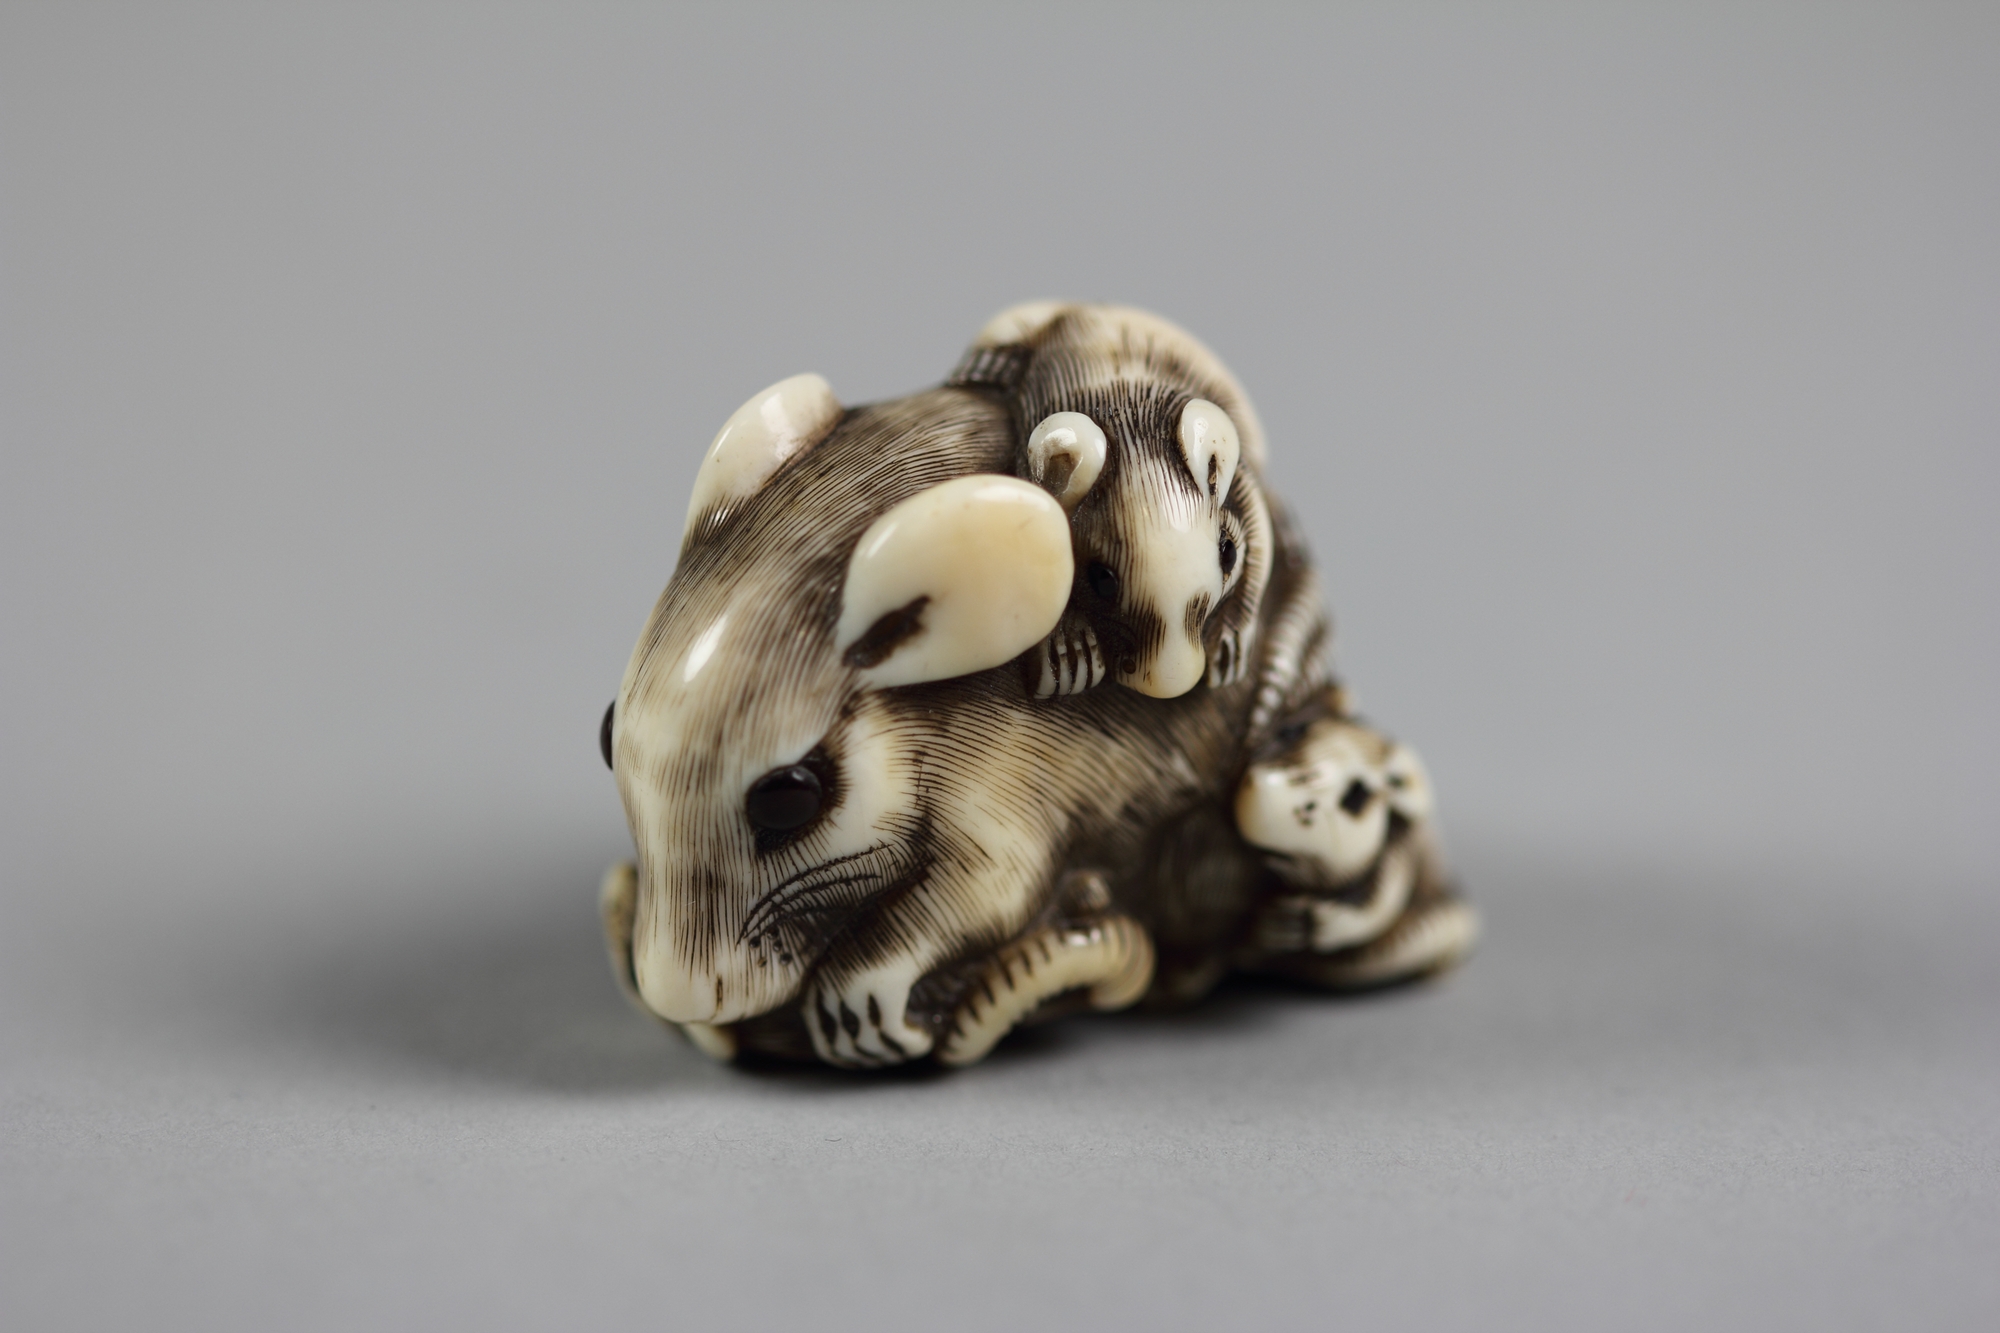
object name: netsuke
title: Rat with Three Young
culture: japanese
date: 1834-1866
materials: ivory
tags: mice